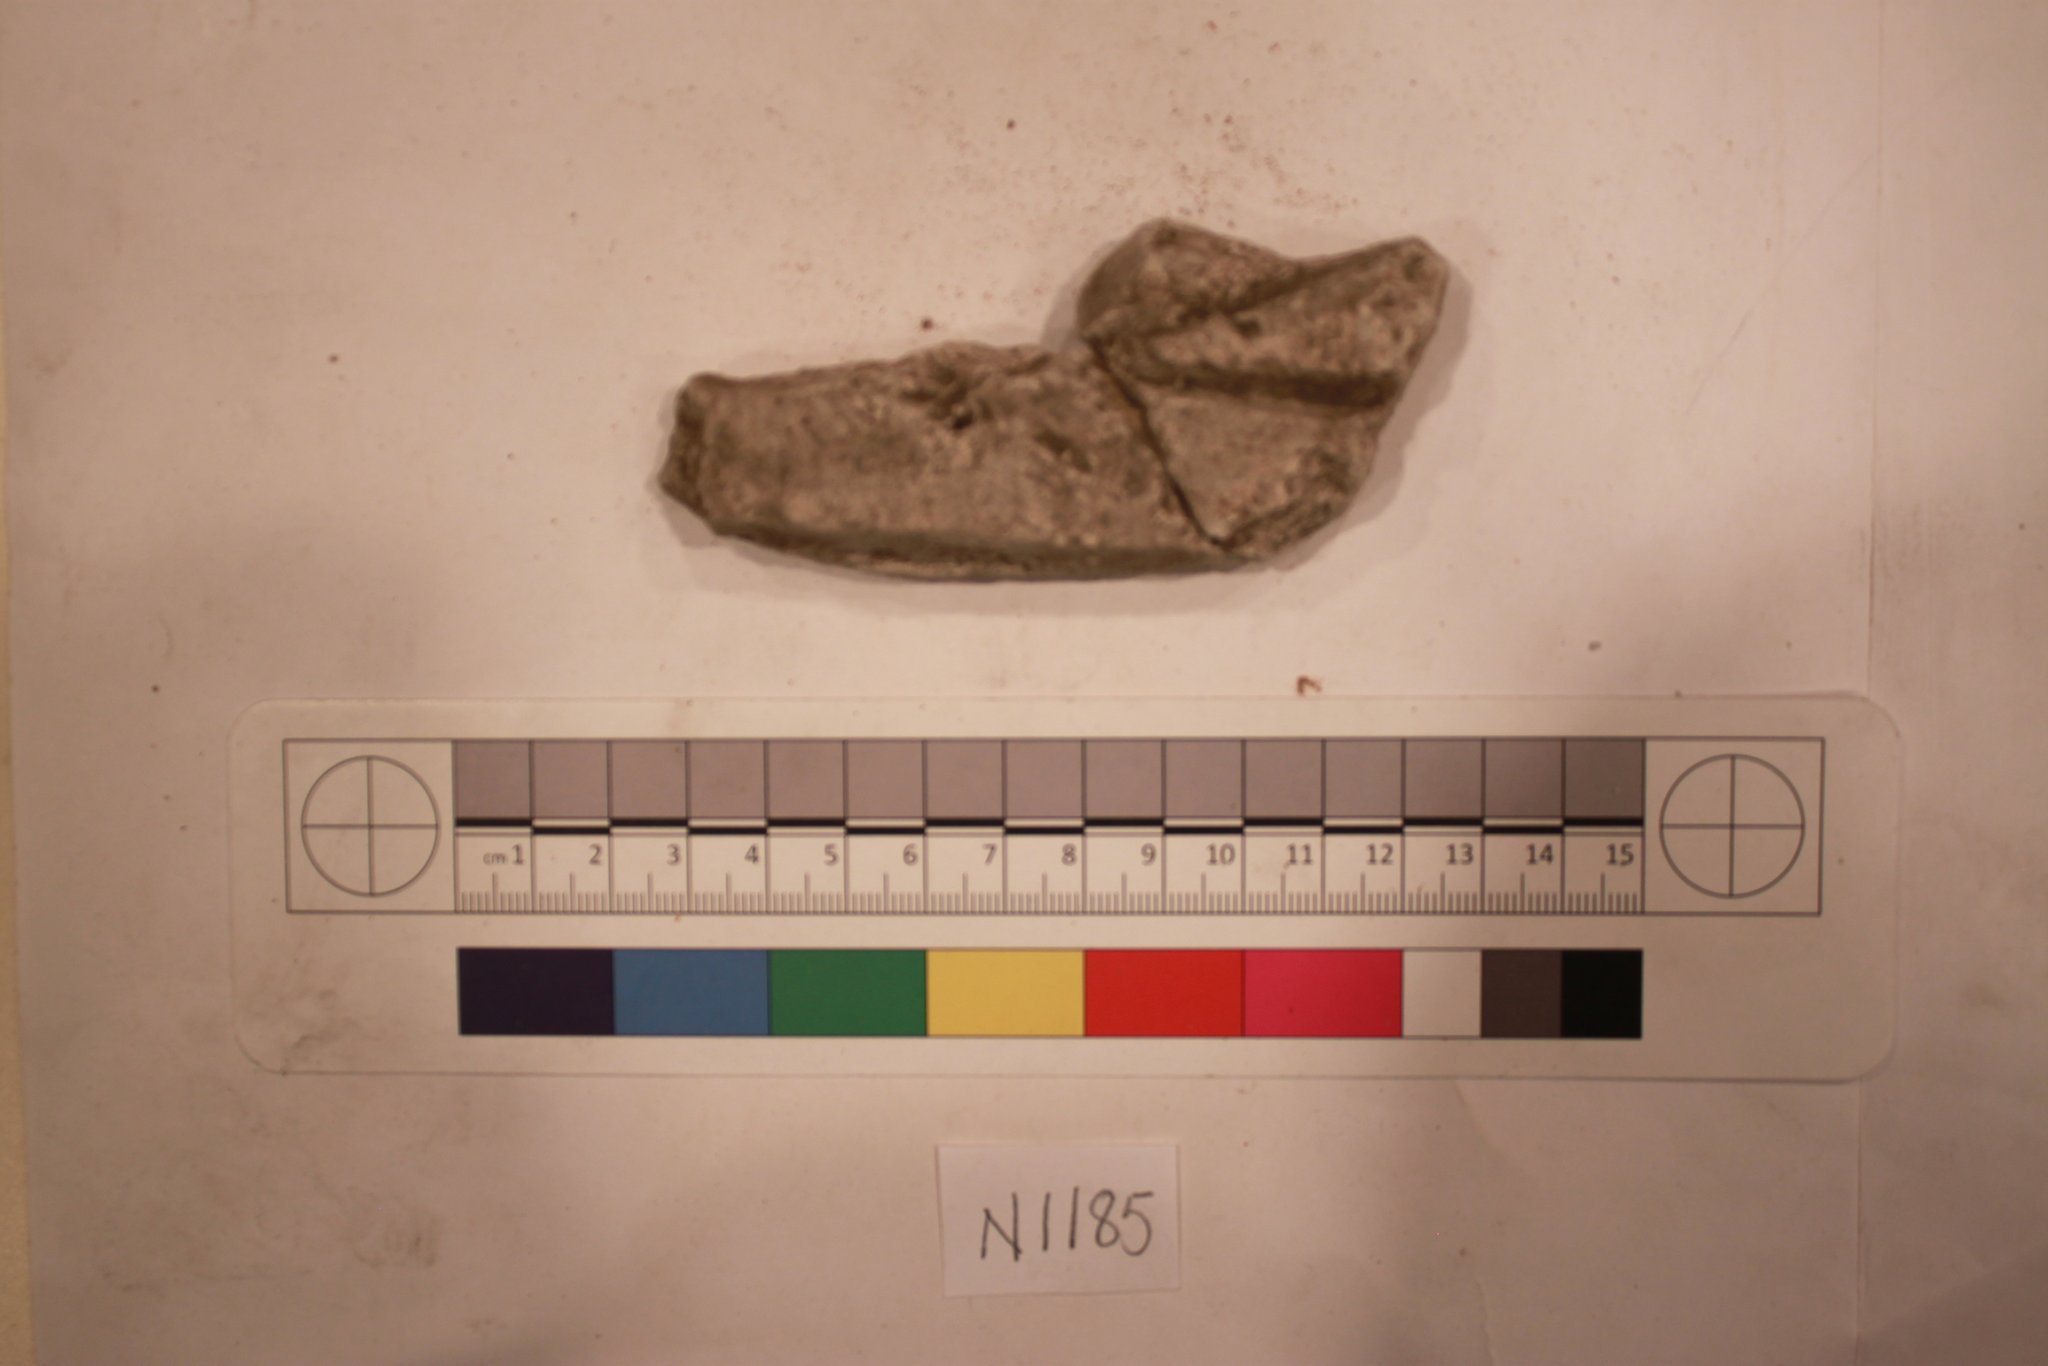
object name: fragment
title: Stucco Fragment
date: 701-1200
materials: plaster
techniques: carving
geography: iran